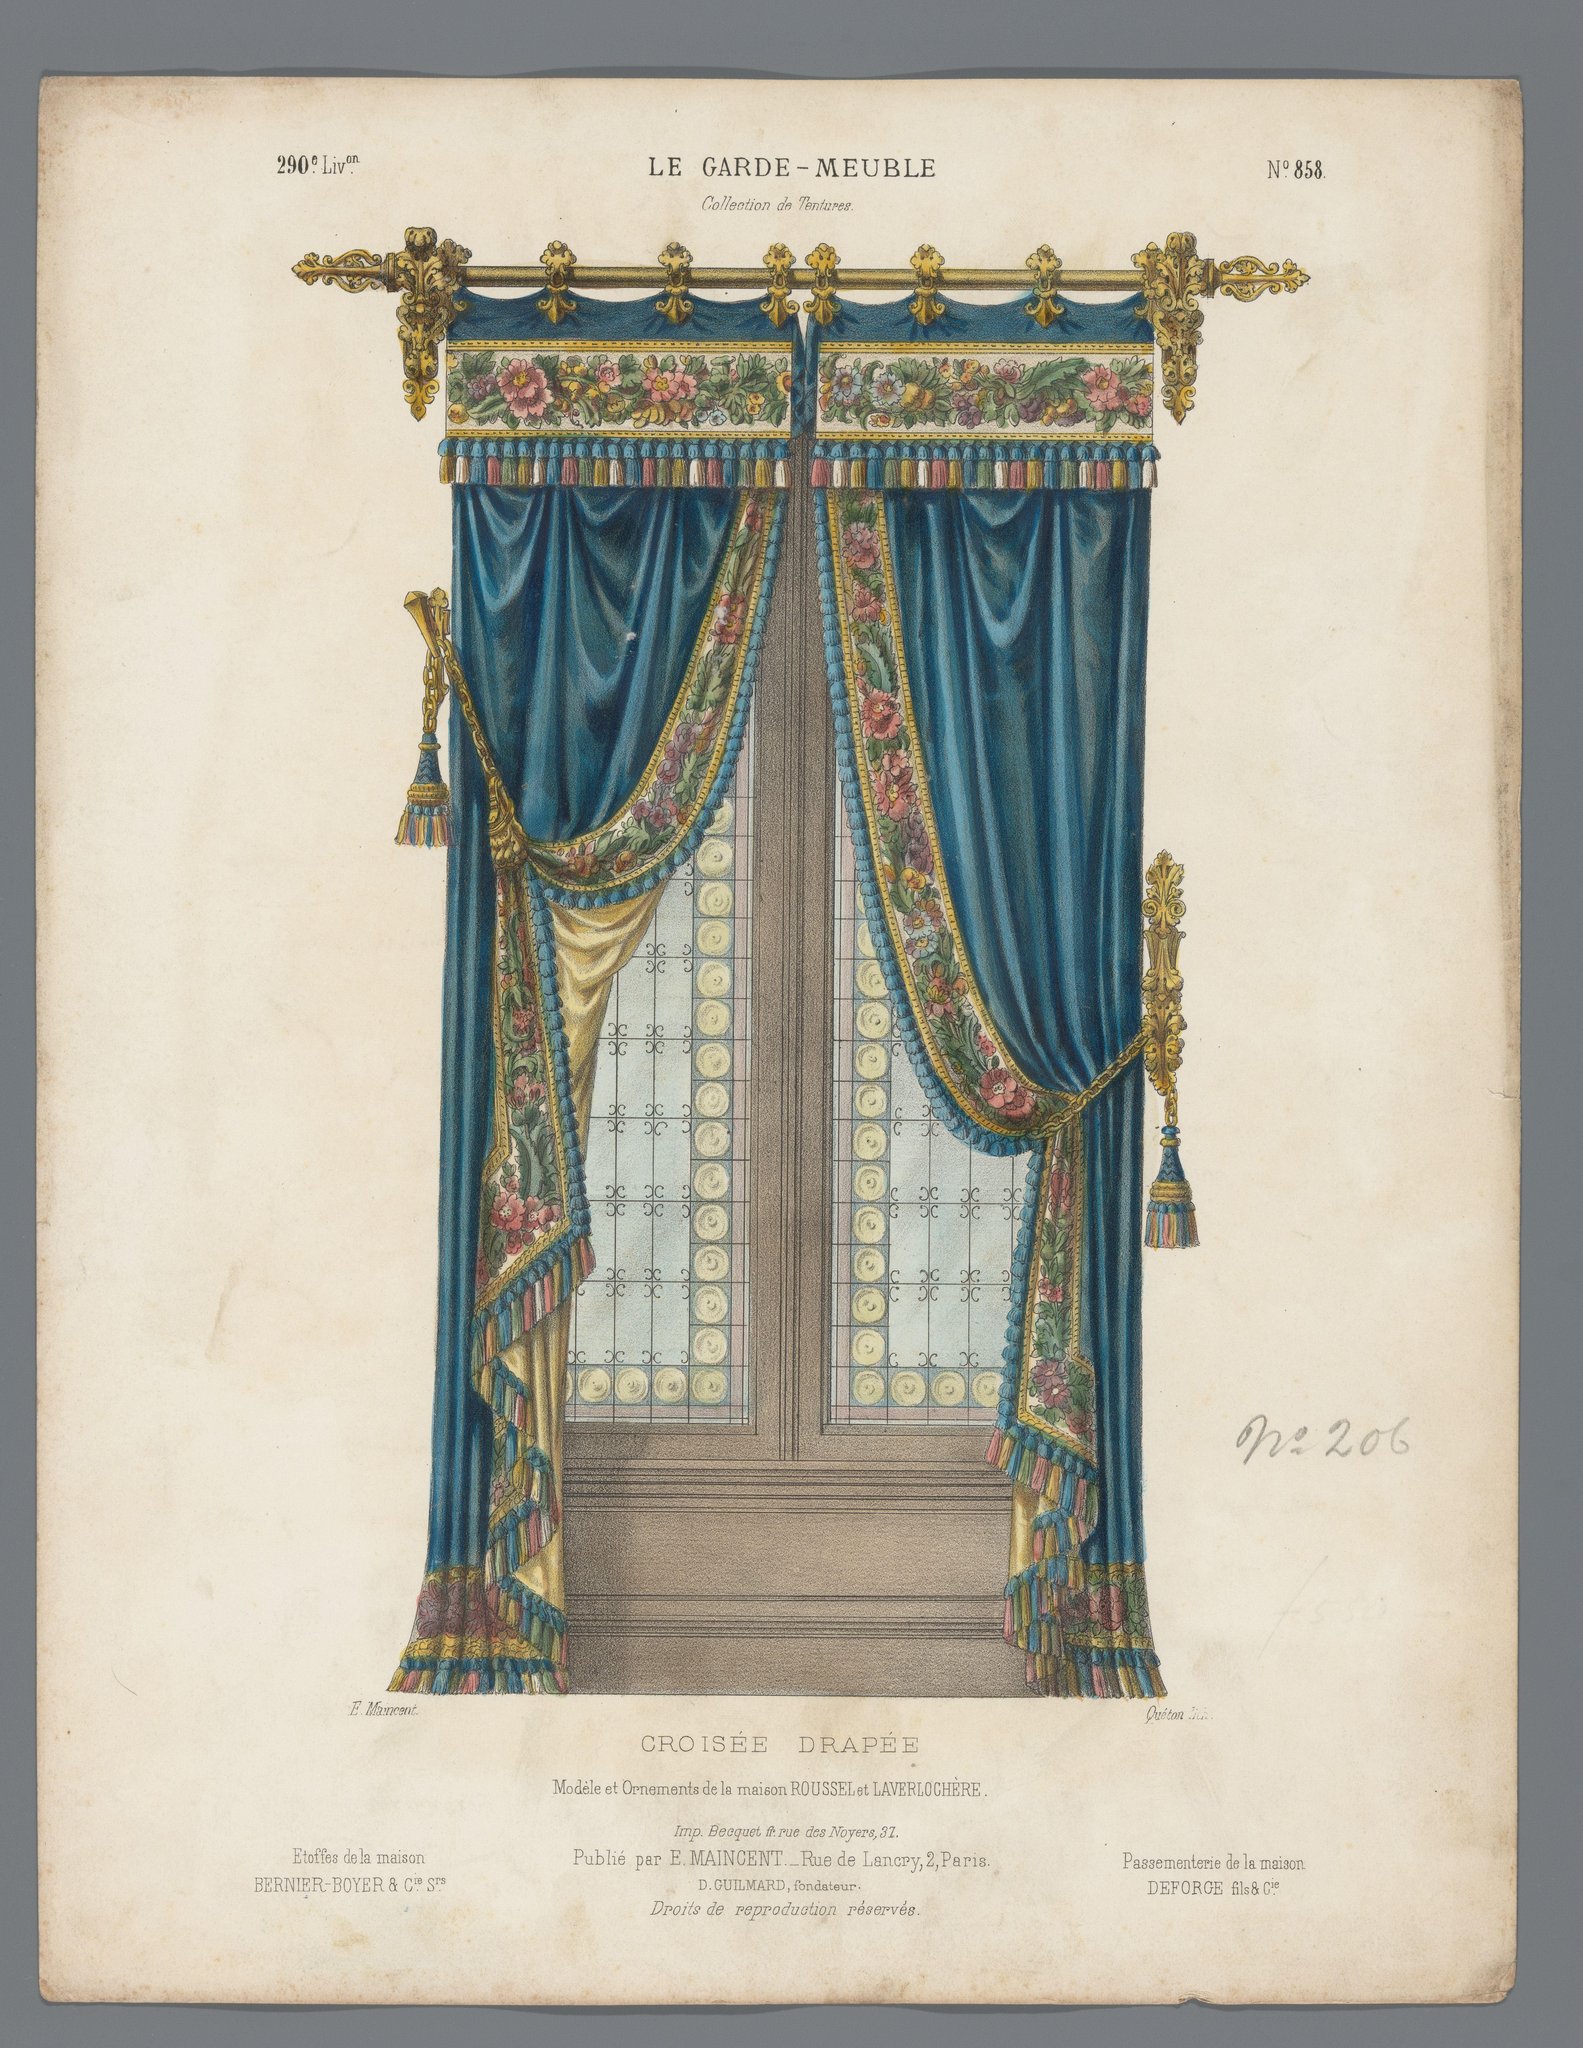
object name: print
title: Le Garde-Meuble / Collection de Tentures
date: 1885-1895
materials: paper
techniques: hand coloring, lithograph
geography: paris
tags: window, hangings and drapery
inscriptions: : ‘Droits de reproduction réservés.’, annotation: ‘No. 206’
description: Kruisvenster met gedrapeerde gordijnen. Prent uit 290e Livraison.